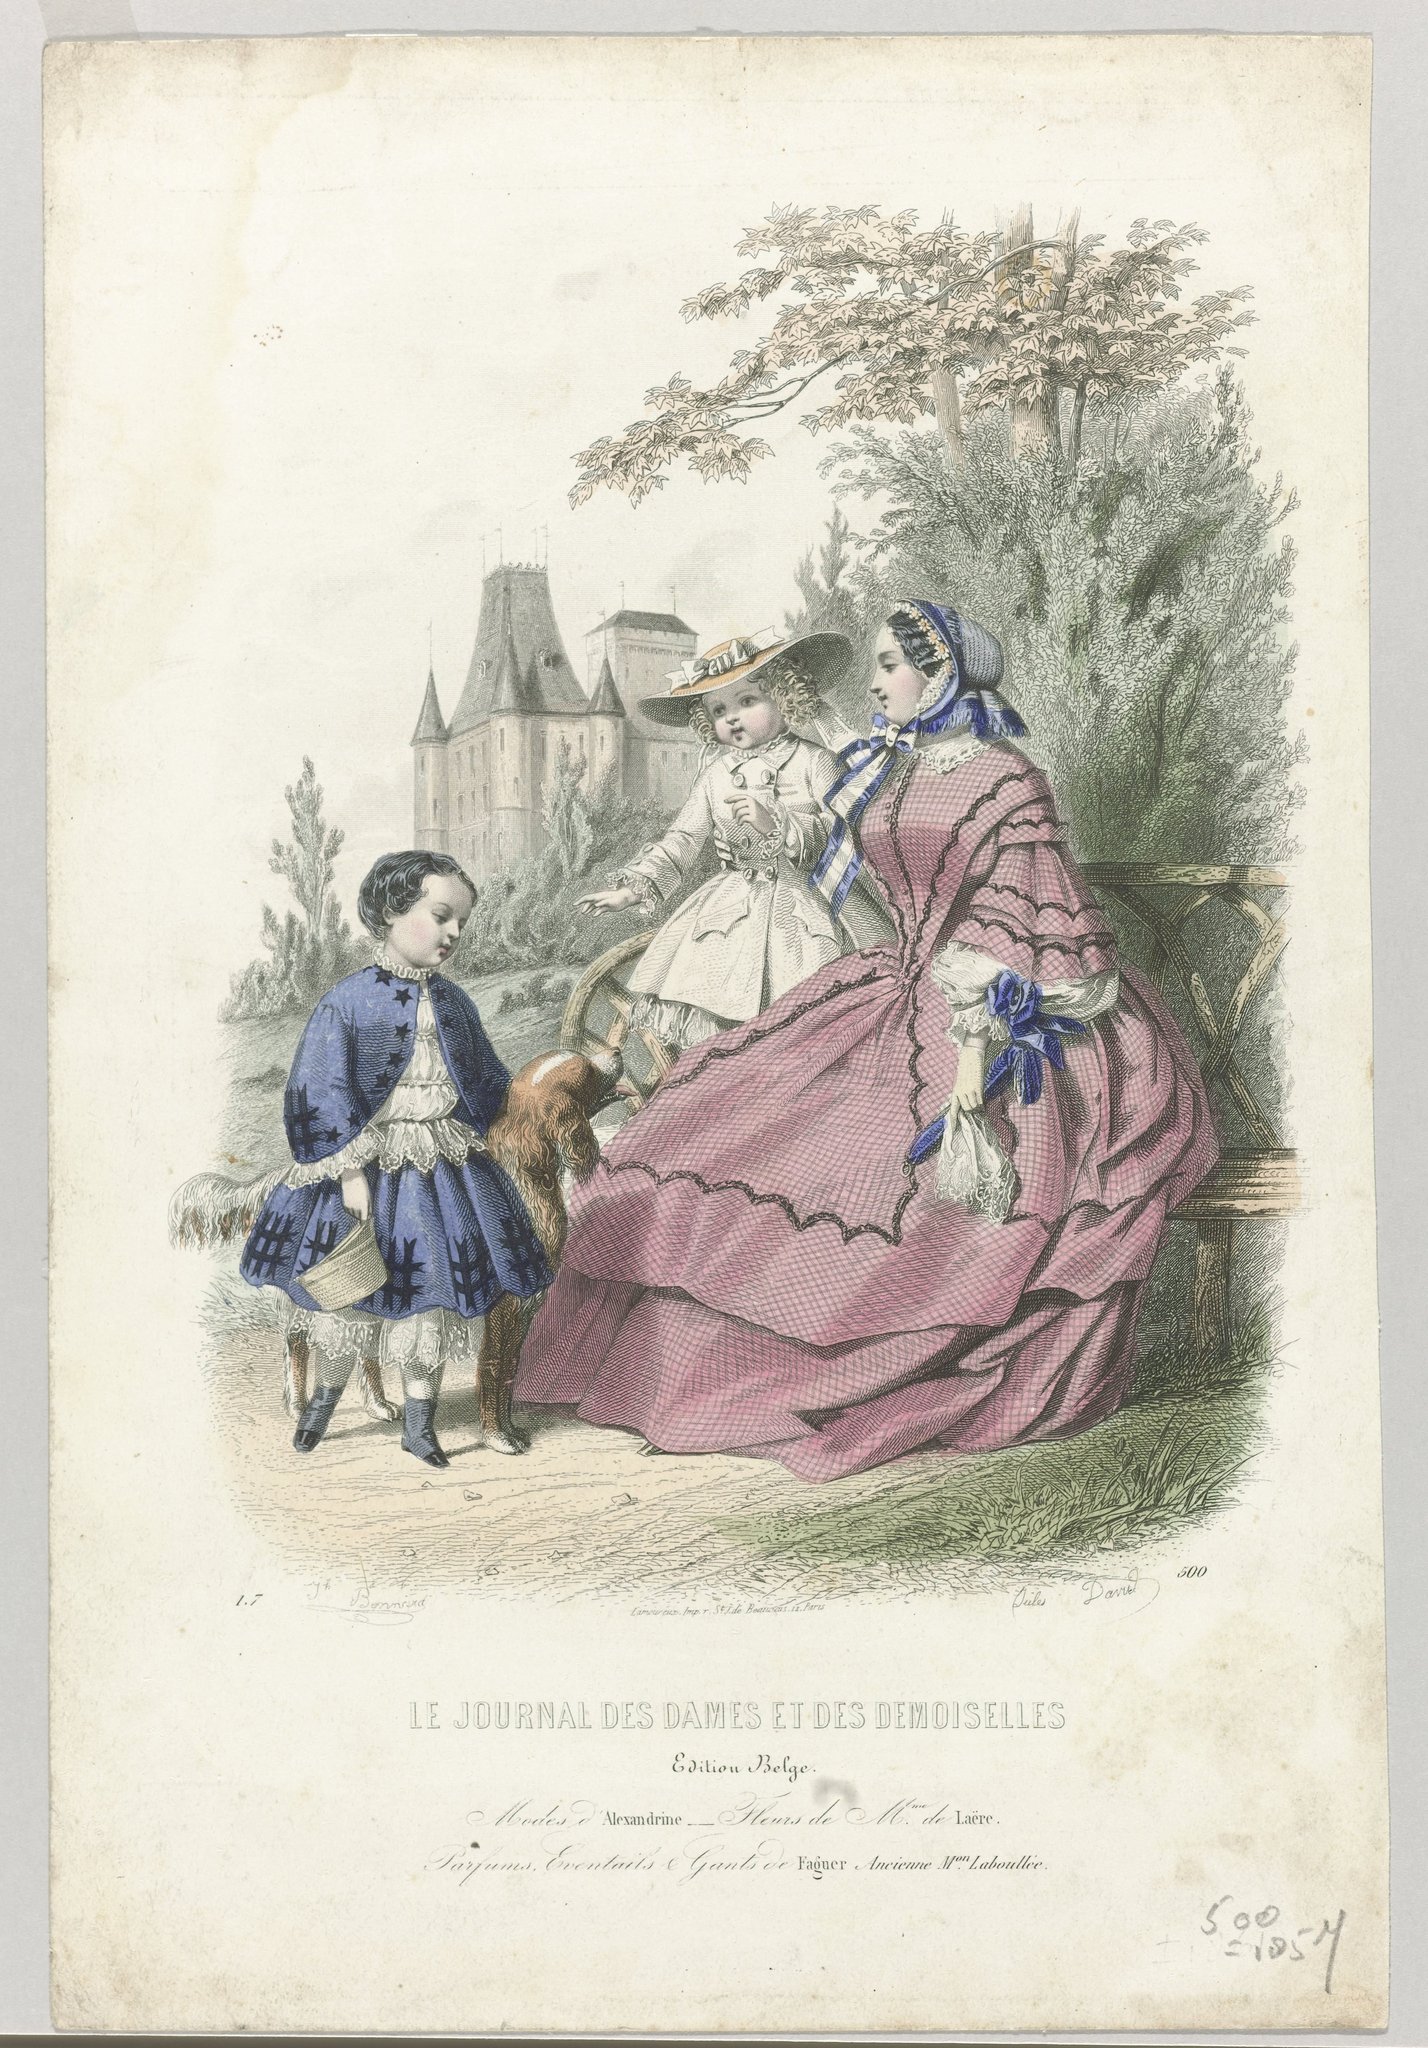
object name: fashion print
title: Le Journal des Dames et des Demoiselles, 1857, No. 500, Edition Belge: Modes (...)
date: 1857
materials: paper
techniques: engraving, hand coloring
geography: paris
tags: flowers, handkerchief (+ women's clothes), clothes, costume (+ children's clothes), gloves, mittens (short gloves) (+ women's clothes), head-gear (+ women's clothes), fashion plates, fan (+ women's clothes), neck-gear ~ clothing (+ women's clothes), dog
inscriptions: caption: ‘Modes d'Alexandrine_ Fleurs de M.me de Laëre. Parfums, Eventails & Gants de Faguer Ancienne M.on Laboullée.’, title: ‘Le Journal des Dames et des Demoiselles’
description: Een vrouw, twee kinderen en een hond bij een tuinbank. Op de achtergrond een landgoed. Volgens het onderschrift: 'modes' van Alexandrine. Hieronder enkele regels reclametekst voor verschillende producten. Prent uit het modetijdschrift Le Journal des Dames et des Demoiselles (1841-1902).